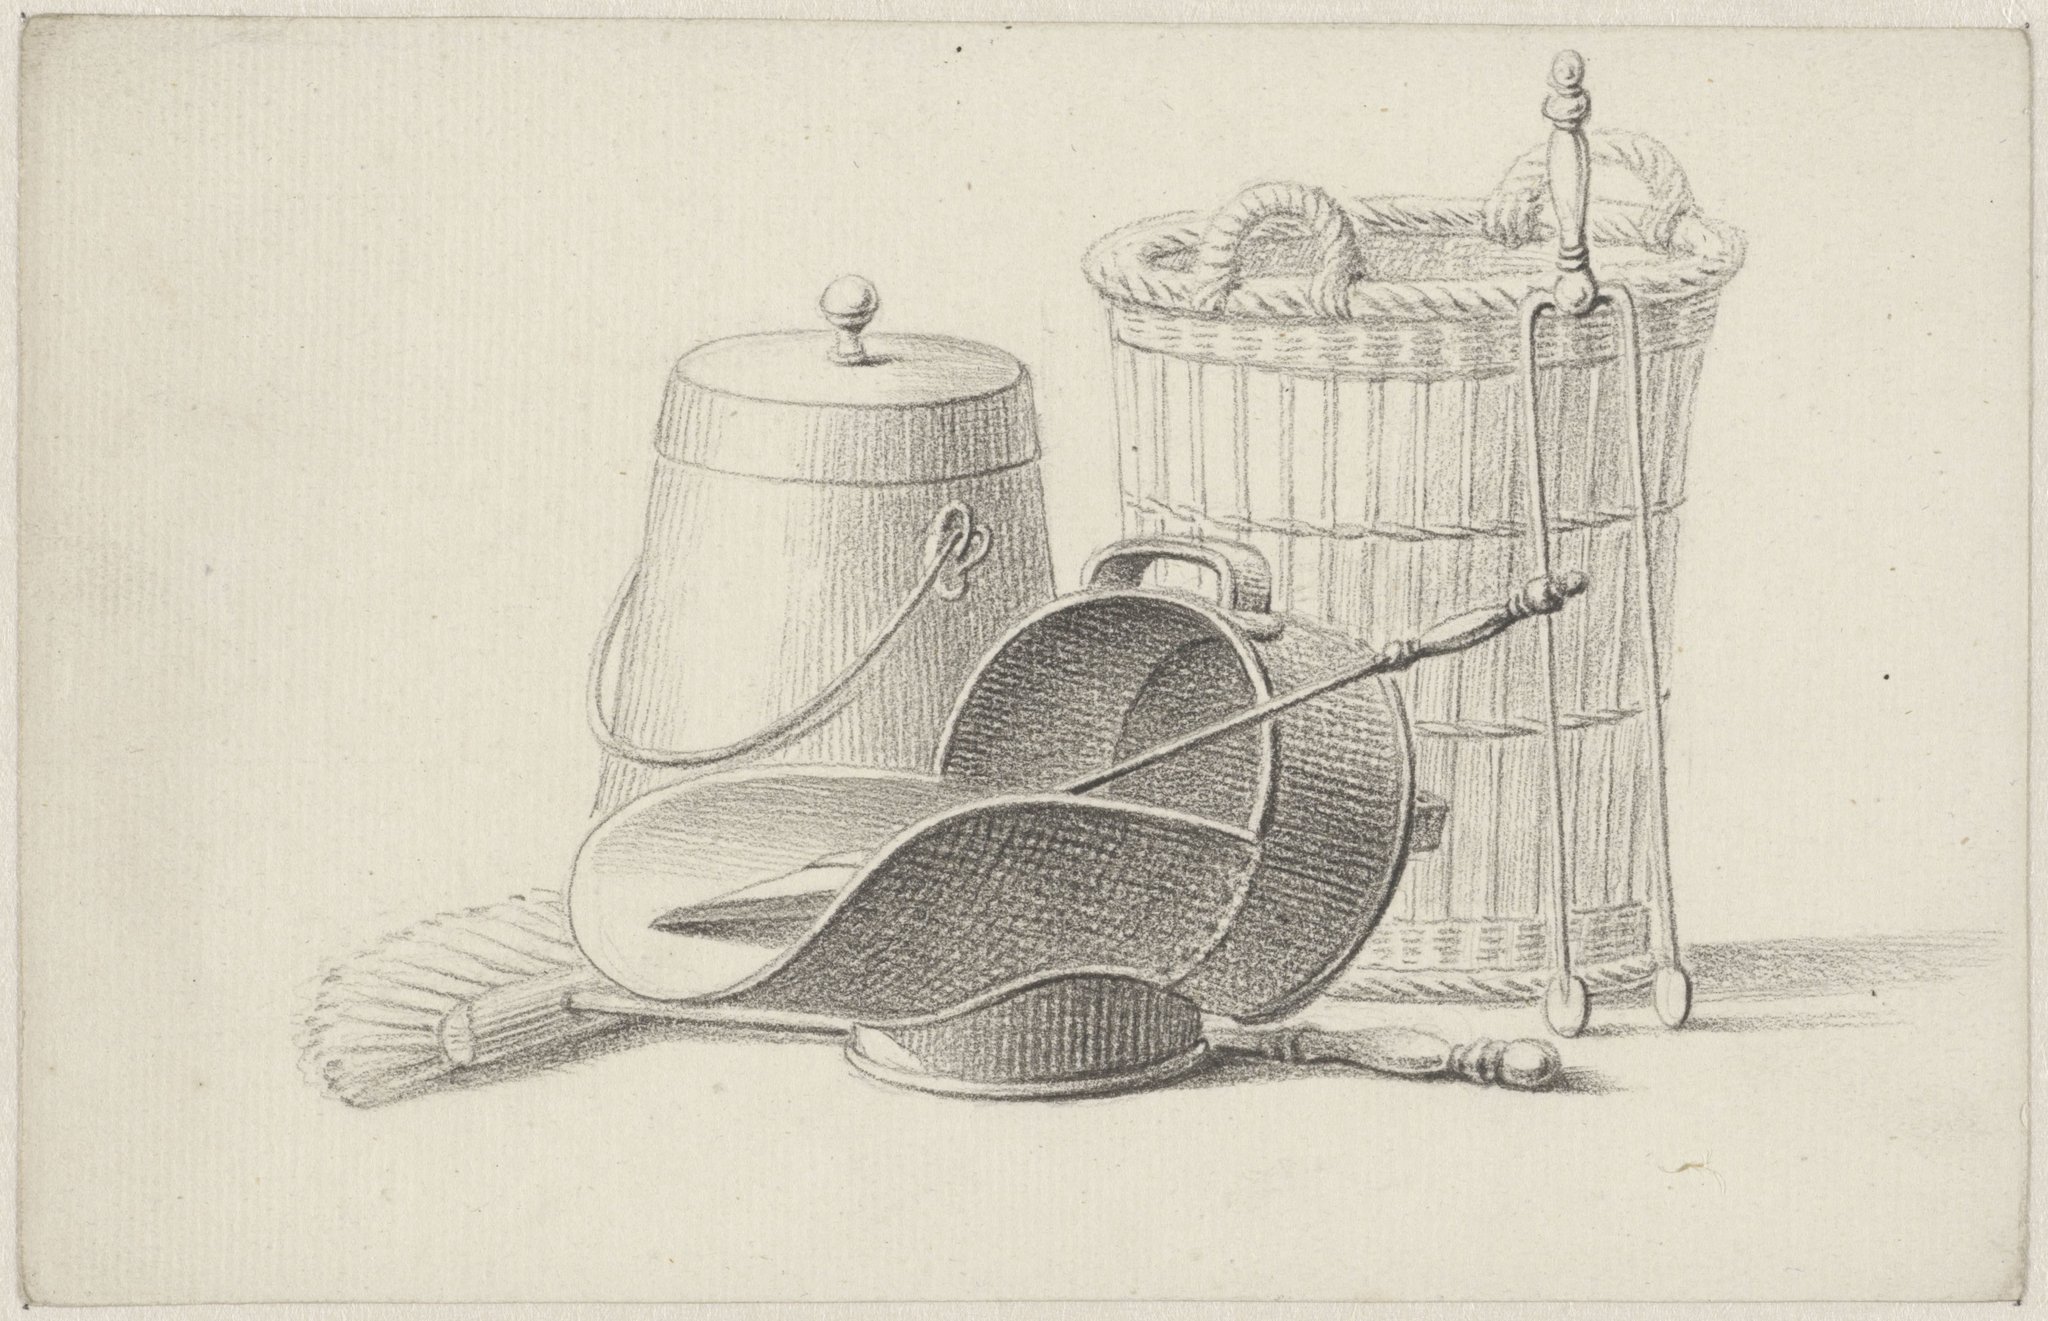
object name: drawing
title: Stilleven met mand en kolenkit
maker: pieter de goeje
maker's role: draughtsman, print maker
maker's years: 1789-1859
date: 1789-1859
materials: chalk, paper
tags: coal-shovel, coal-bucket, still life of related objects